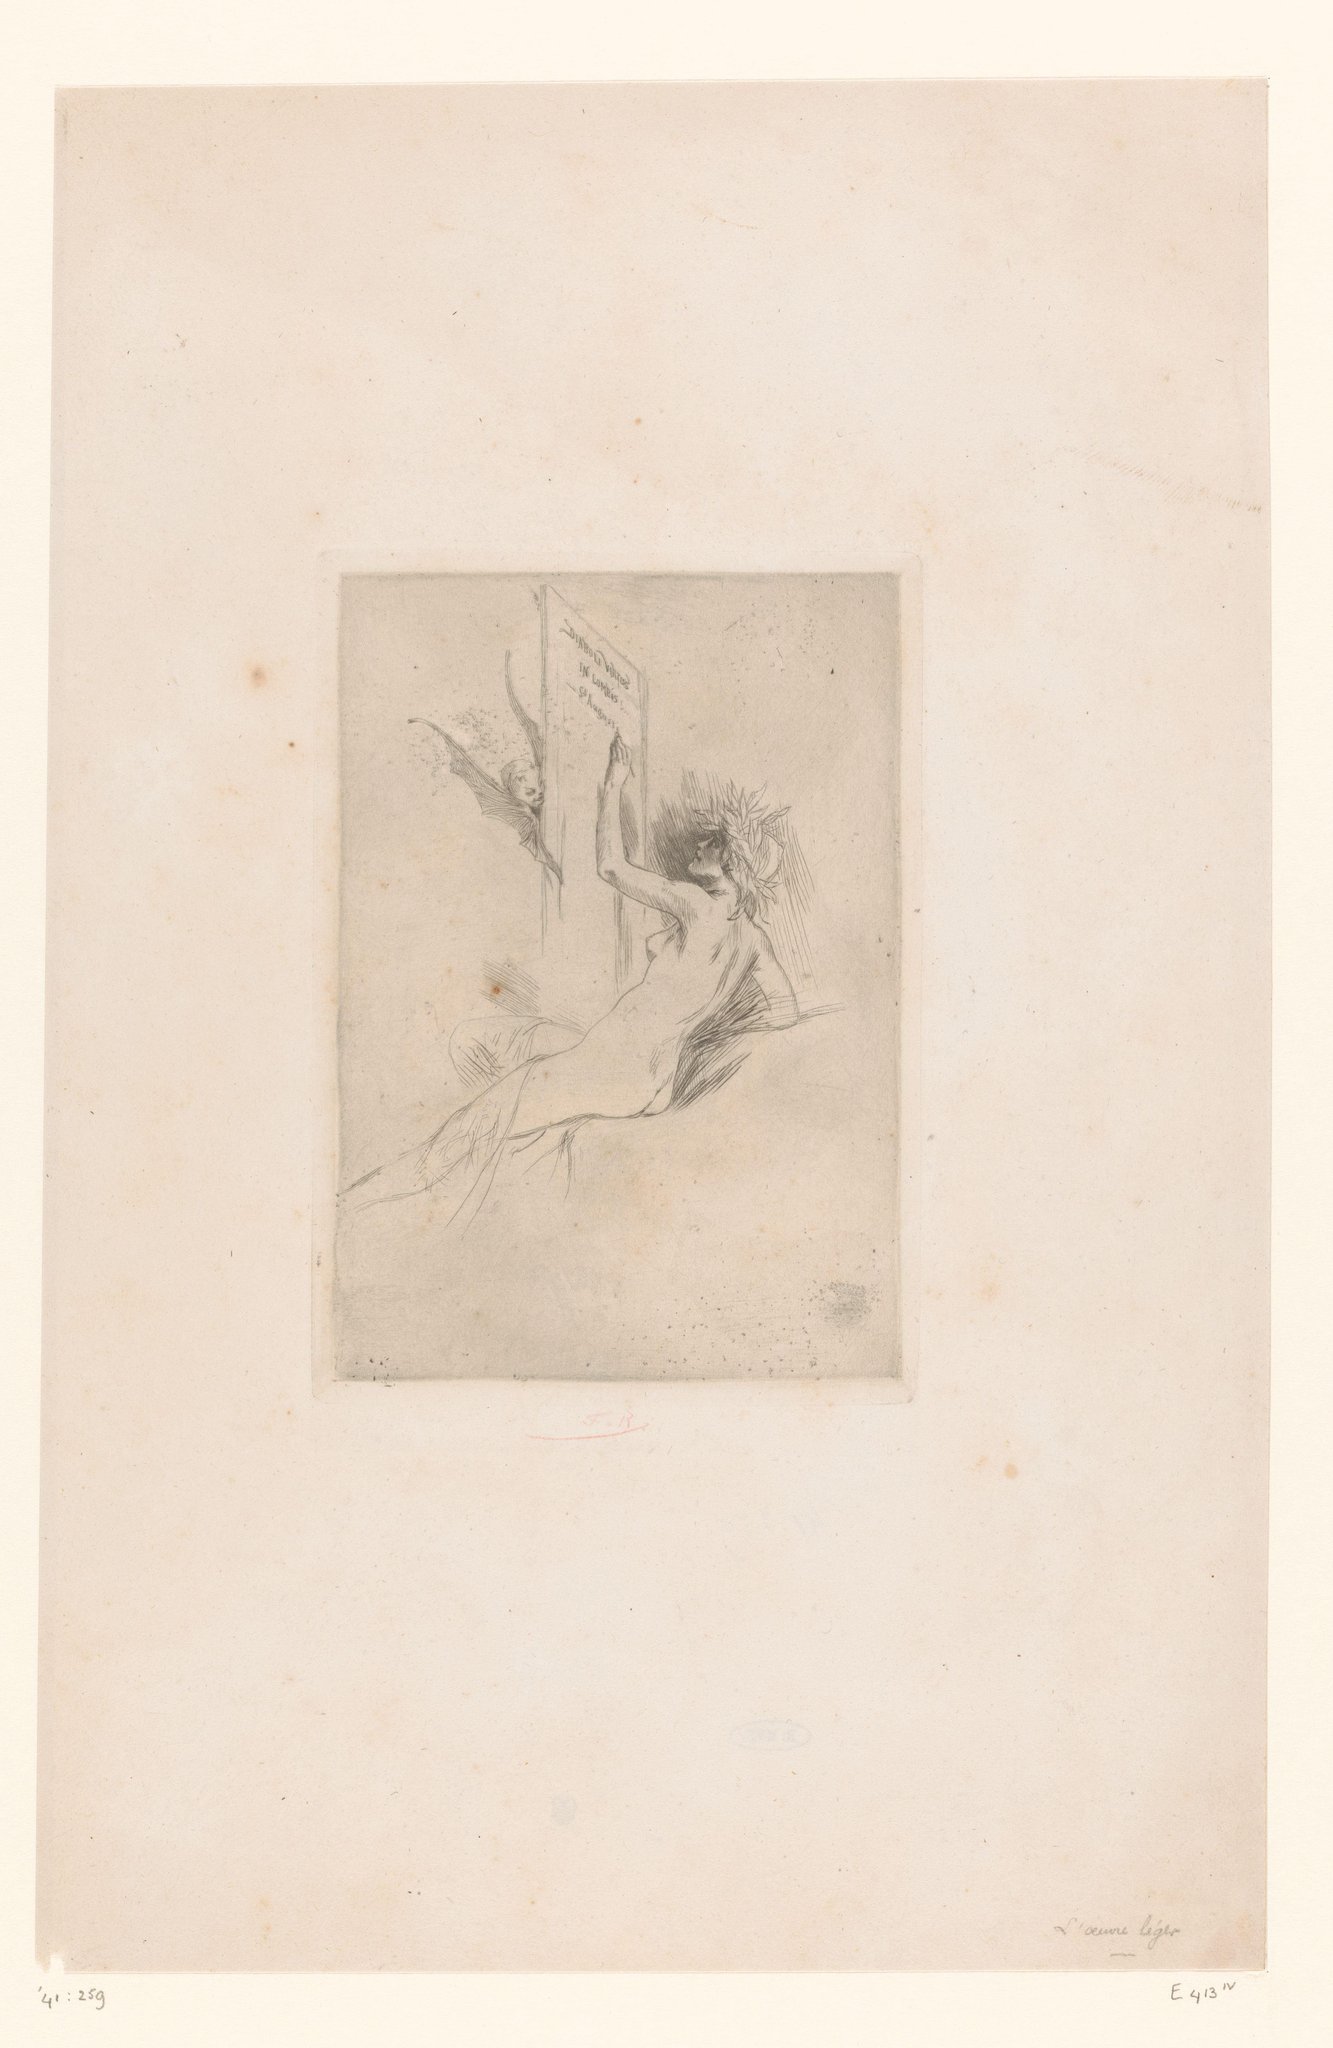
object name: print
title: Naakte vrouw met lauwerkrans schrijft op een plaat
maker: félicien rops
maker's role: draughtsman, print maker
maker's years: 1833-1898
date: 1843-1898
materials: paper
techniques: drypoint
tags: writing tablets, woman (showing herself) undressed, quasi-nude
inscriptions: collector's mark: Lugt 2760, collector's mark: Lugt 2228